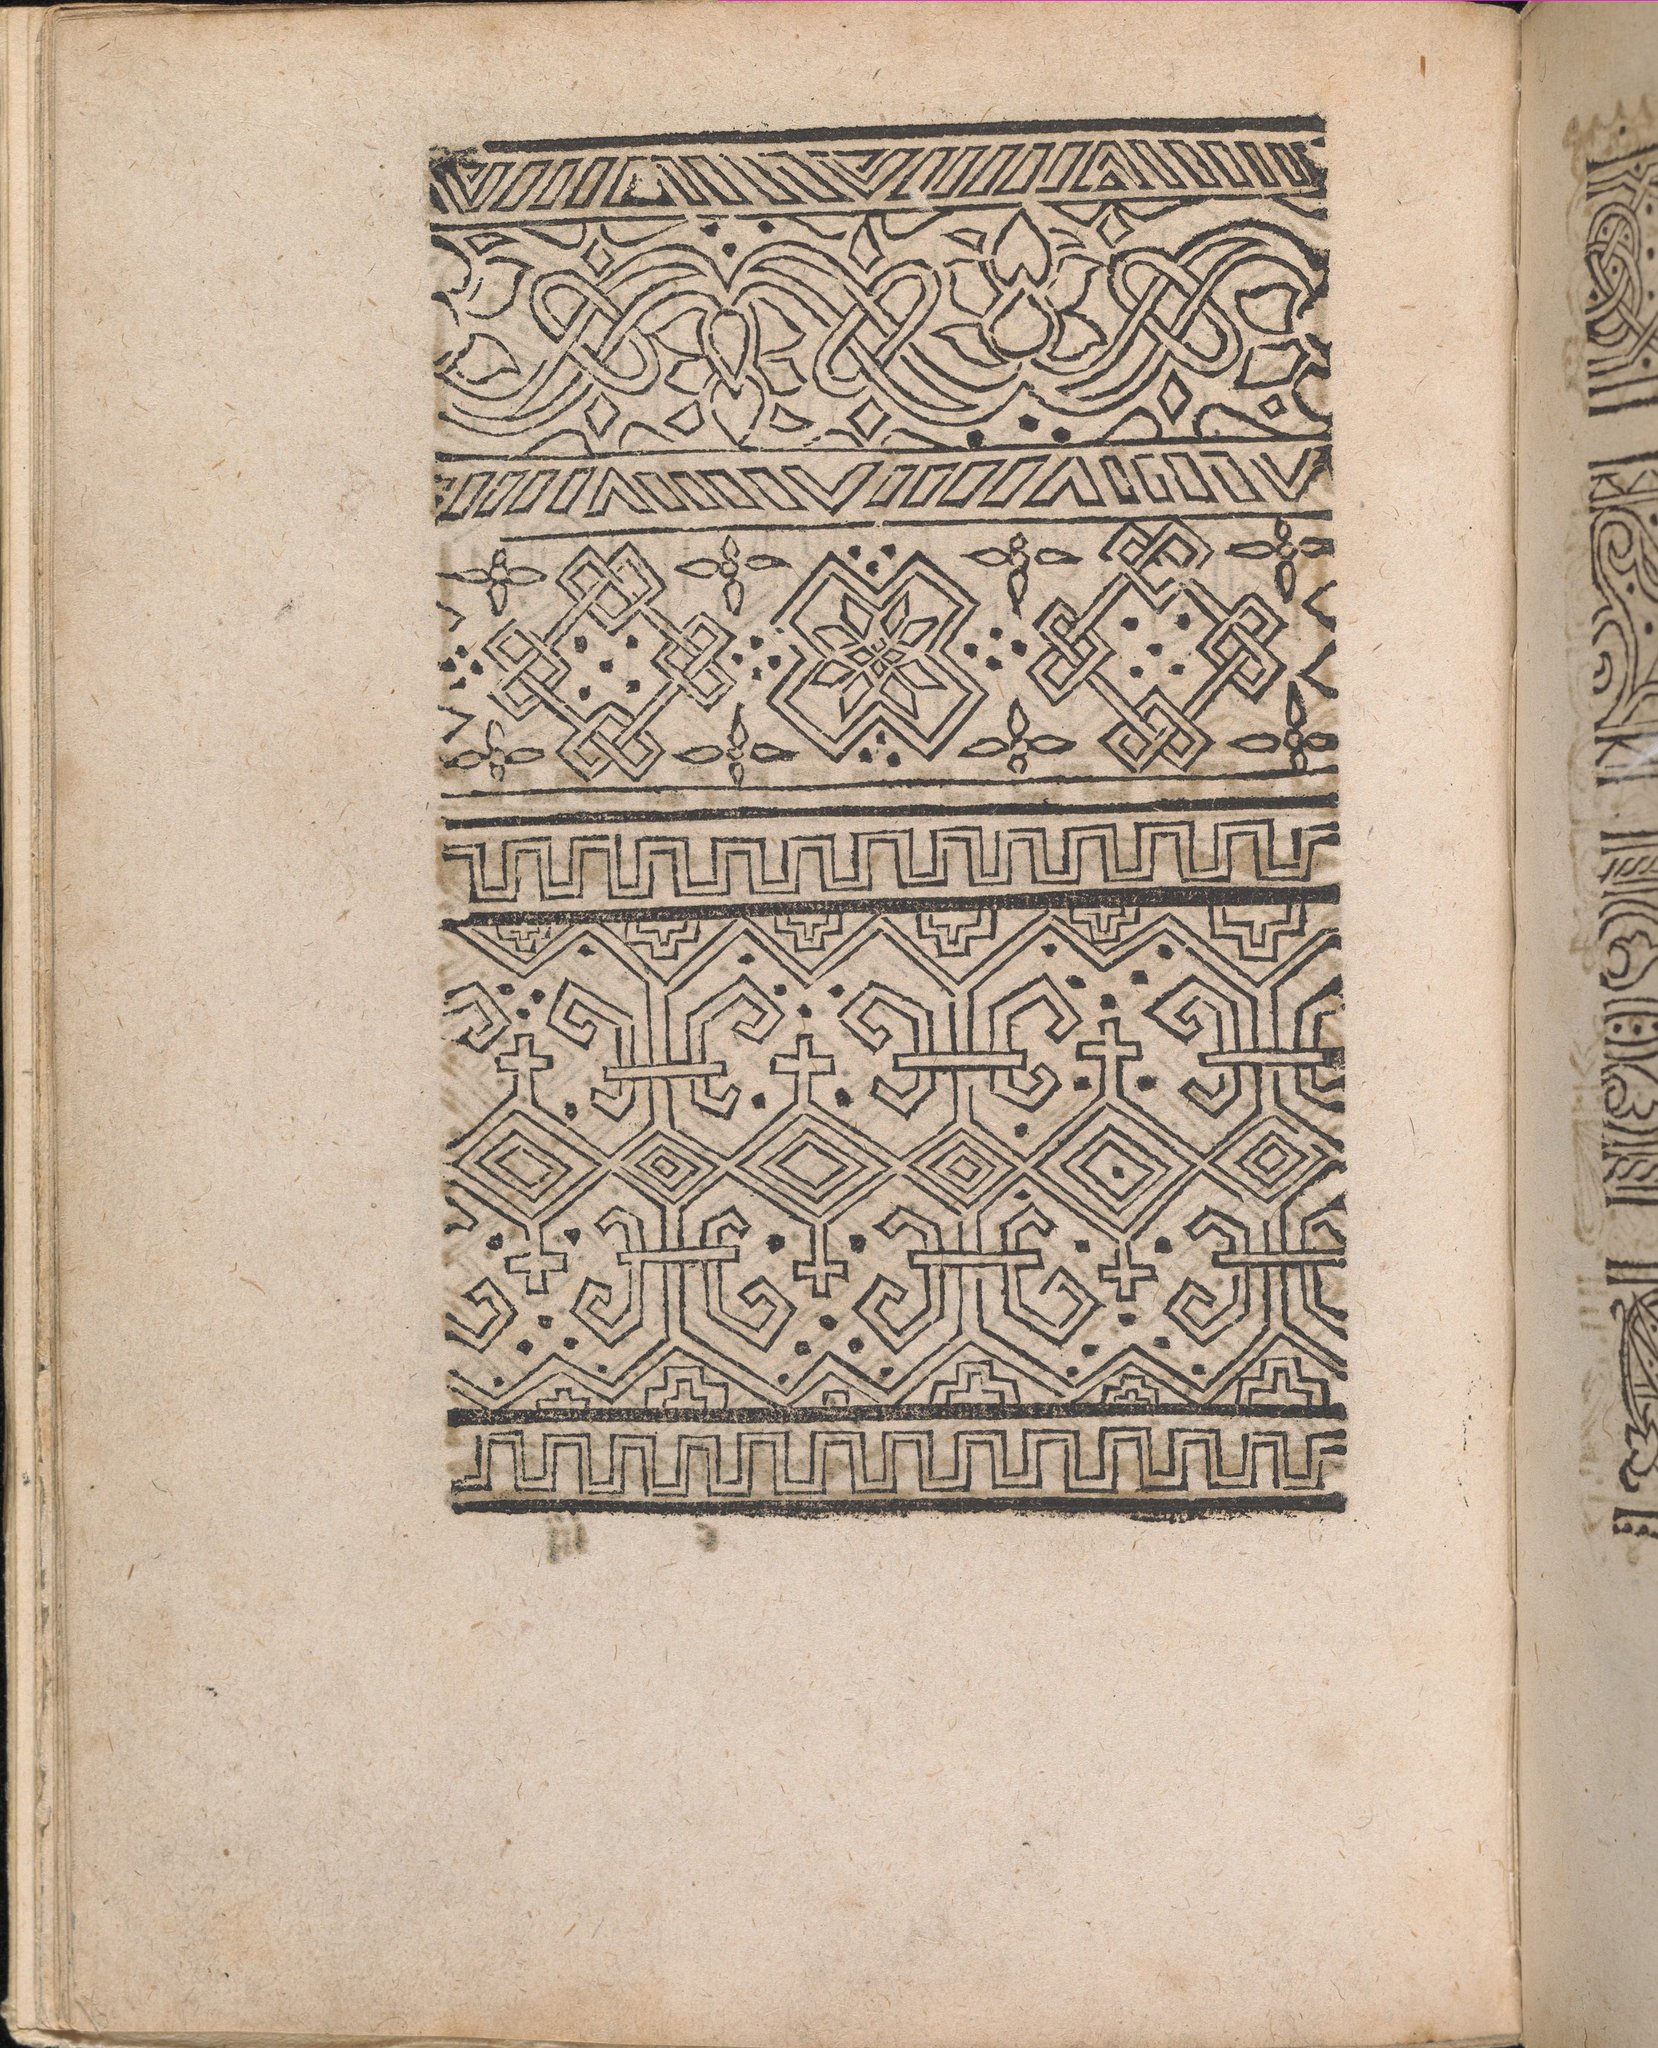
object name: book print ornament architecture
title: Modelbuch aller Art Nehens vn Stickens (Page 11v)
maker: christian egenolff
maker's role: publisher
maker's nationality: german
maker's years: 1502-1555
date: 1535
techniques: woodcut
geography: germany